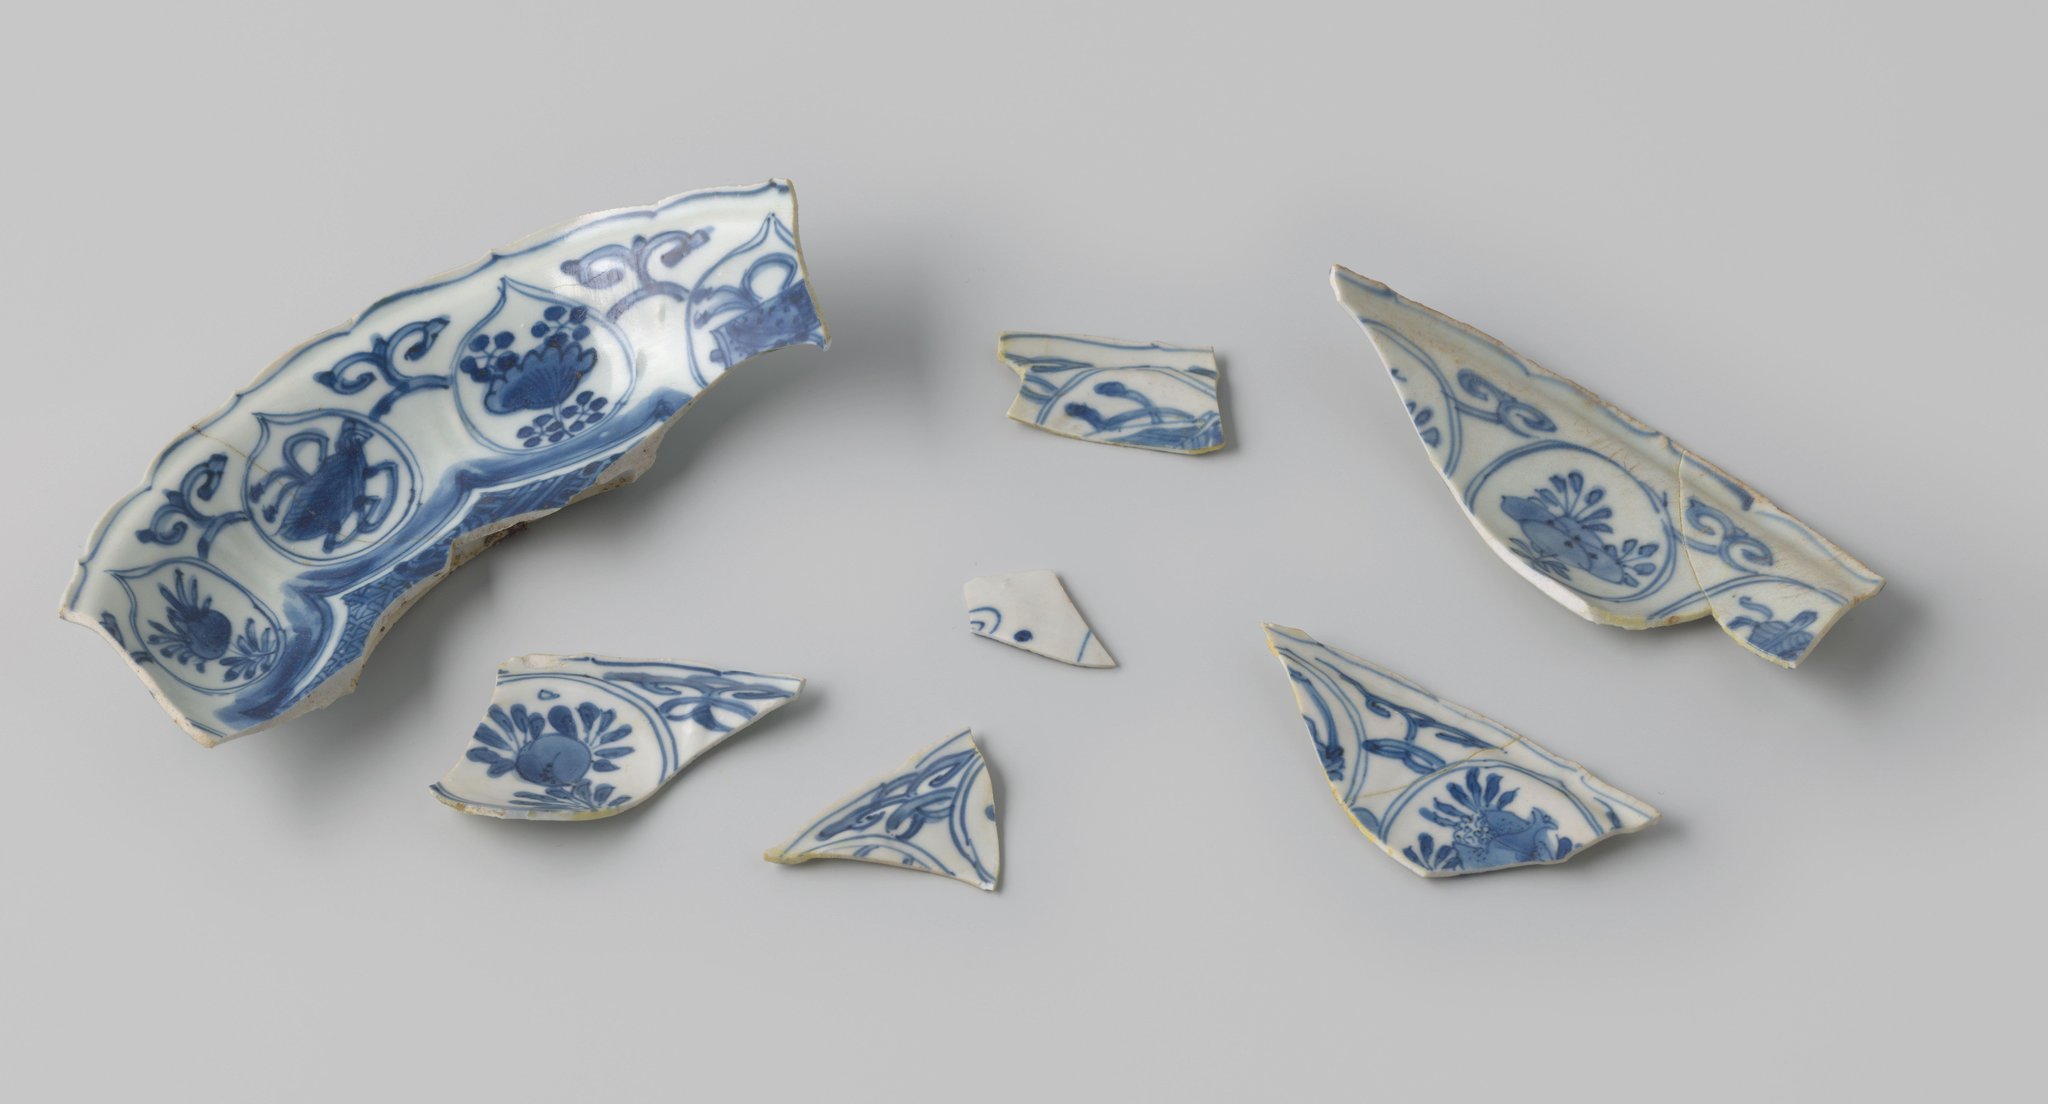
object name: plate dish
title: Scherven van borden uit V.O.C.-schip de 'Witte Leeuw'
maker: Anonymous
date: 1613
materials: bone china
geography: jingdezhen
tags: verenigde oostindische compagnie, sint-helena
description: A dish without a flattened rim. An eight-sided thickly drawn medallion. A central decoration of a grasshopper on a rock under a flower. The medallions decorated alternately with thrice a flower or fruit and twice a symbol.